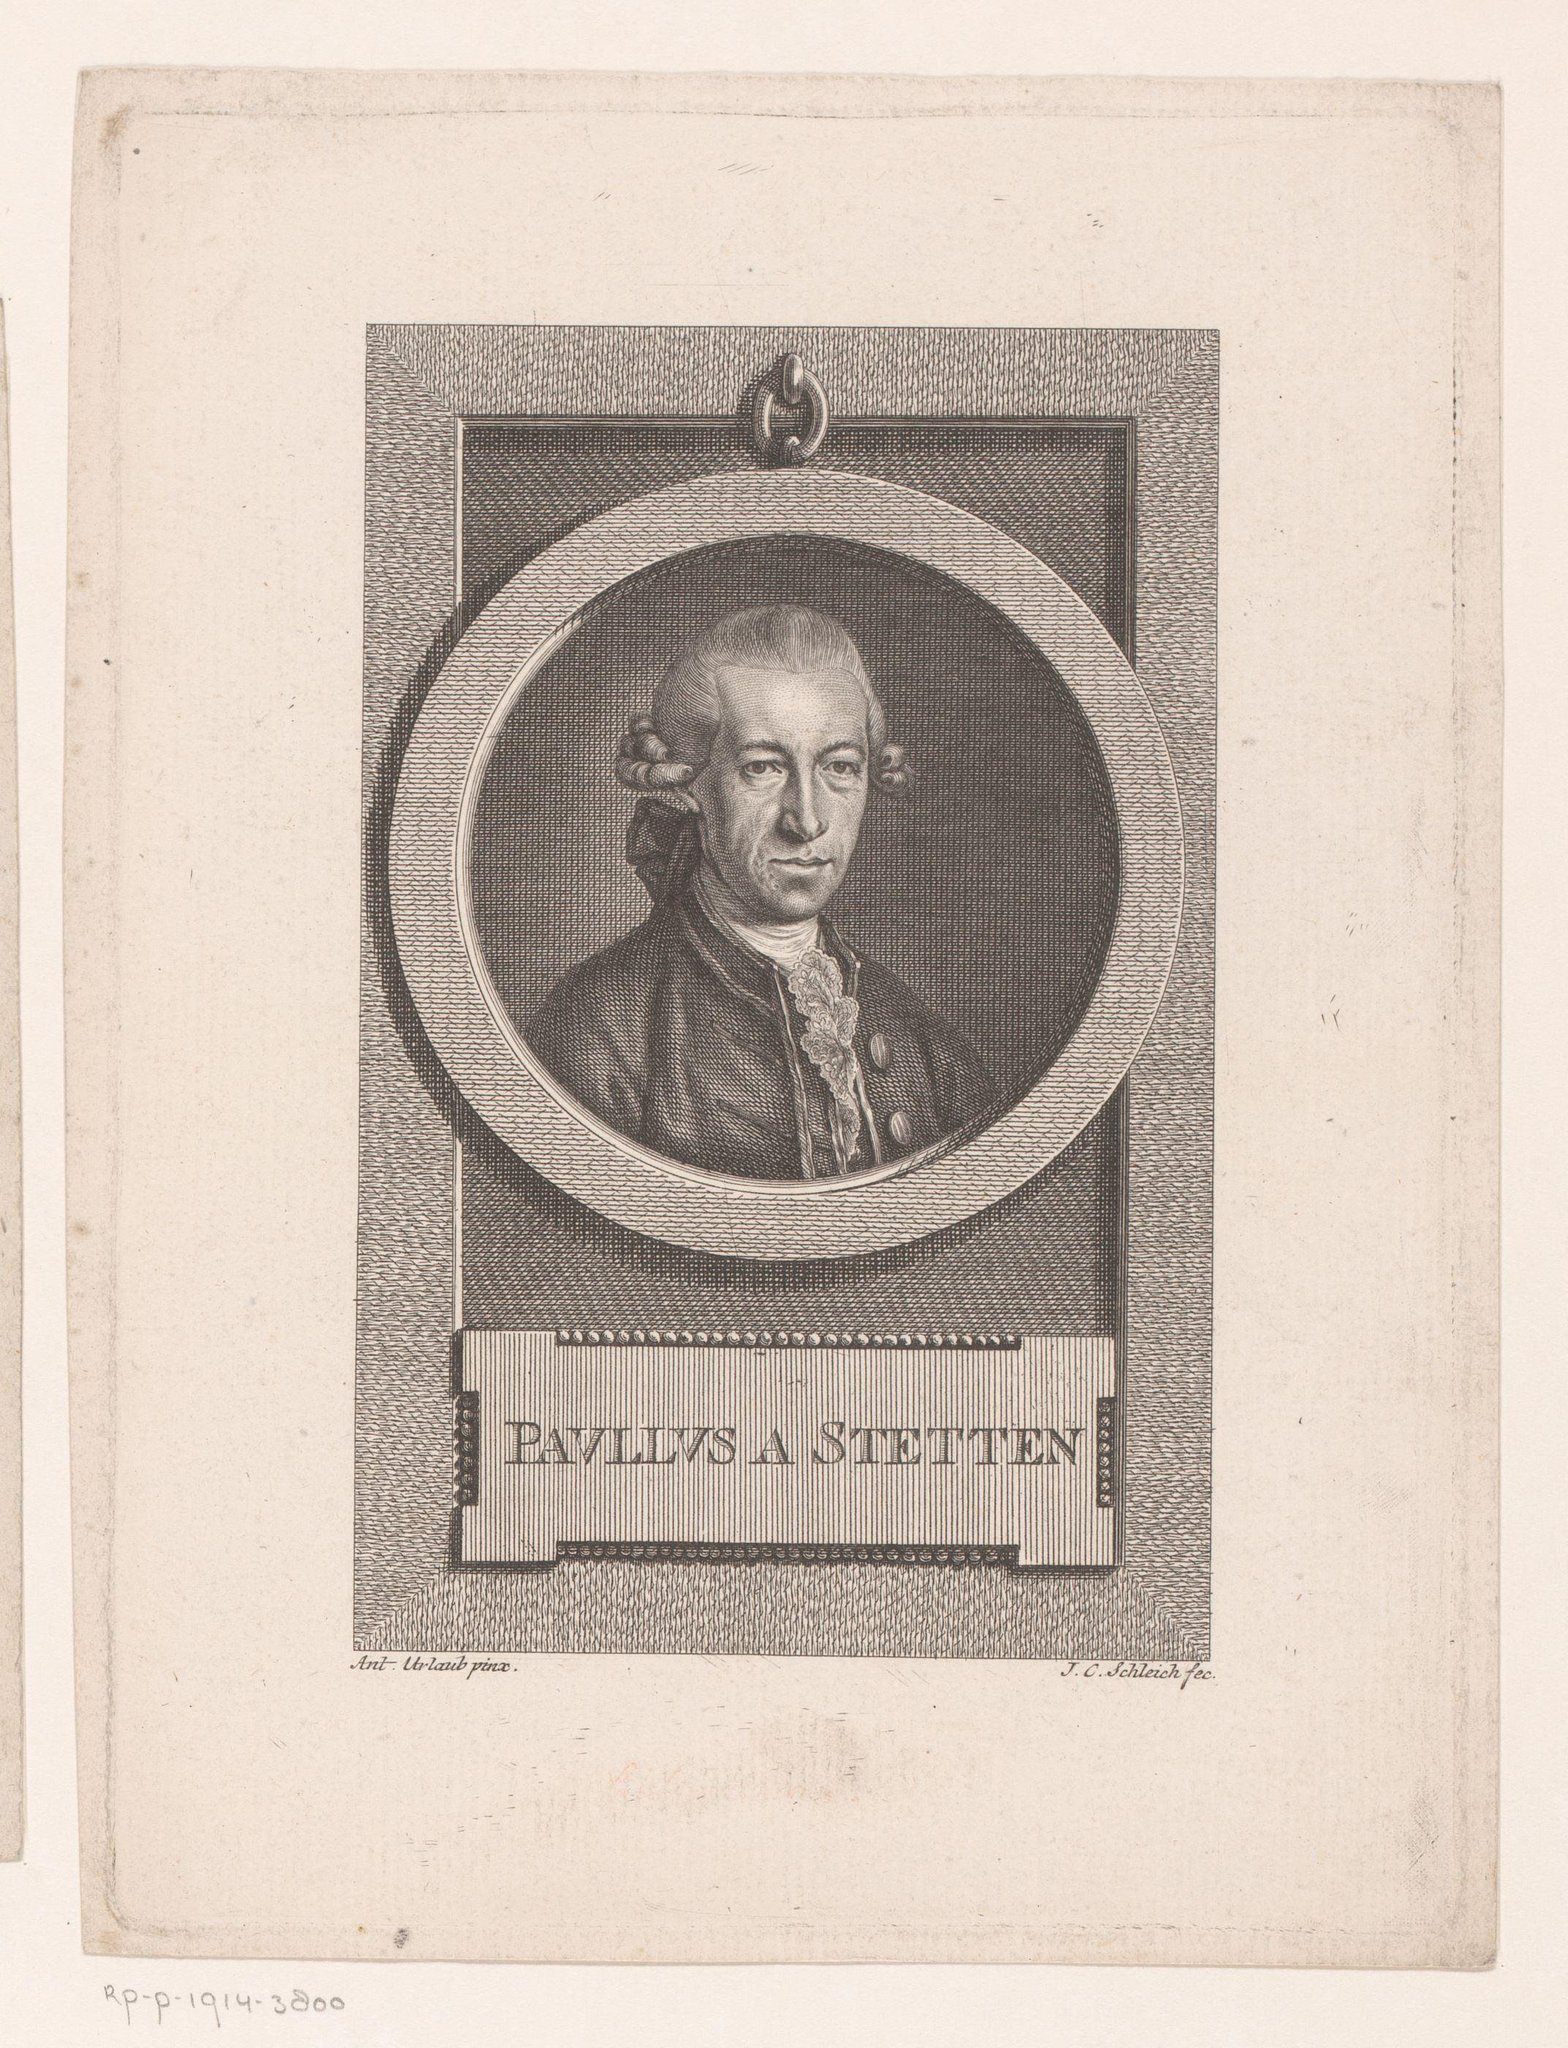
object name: print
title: Portret van Paul von Stetten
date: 1769-1842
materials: paper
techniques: engraving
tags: augsburg, historical persons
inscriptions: collector's mark: Lugt 2228